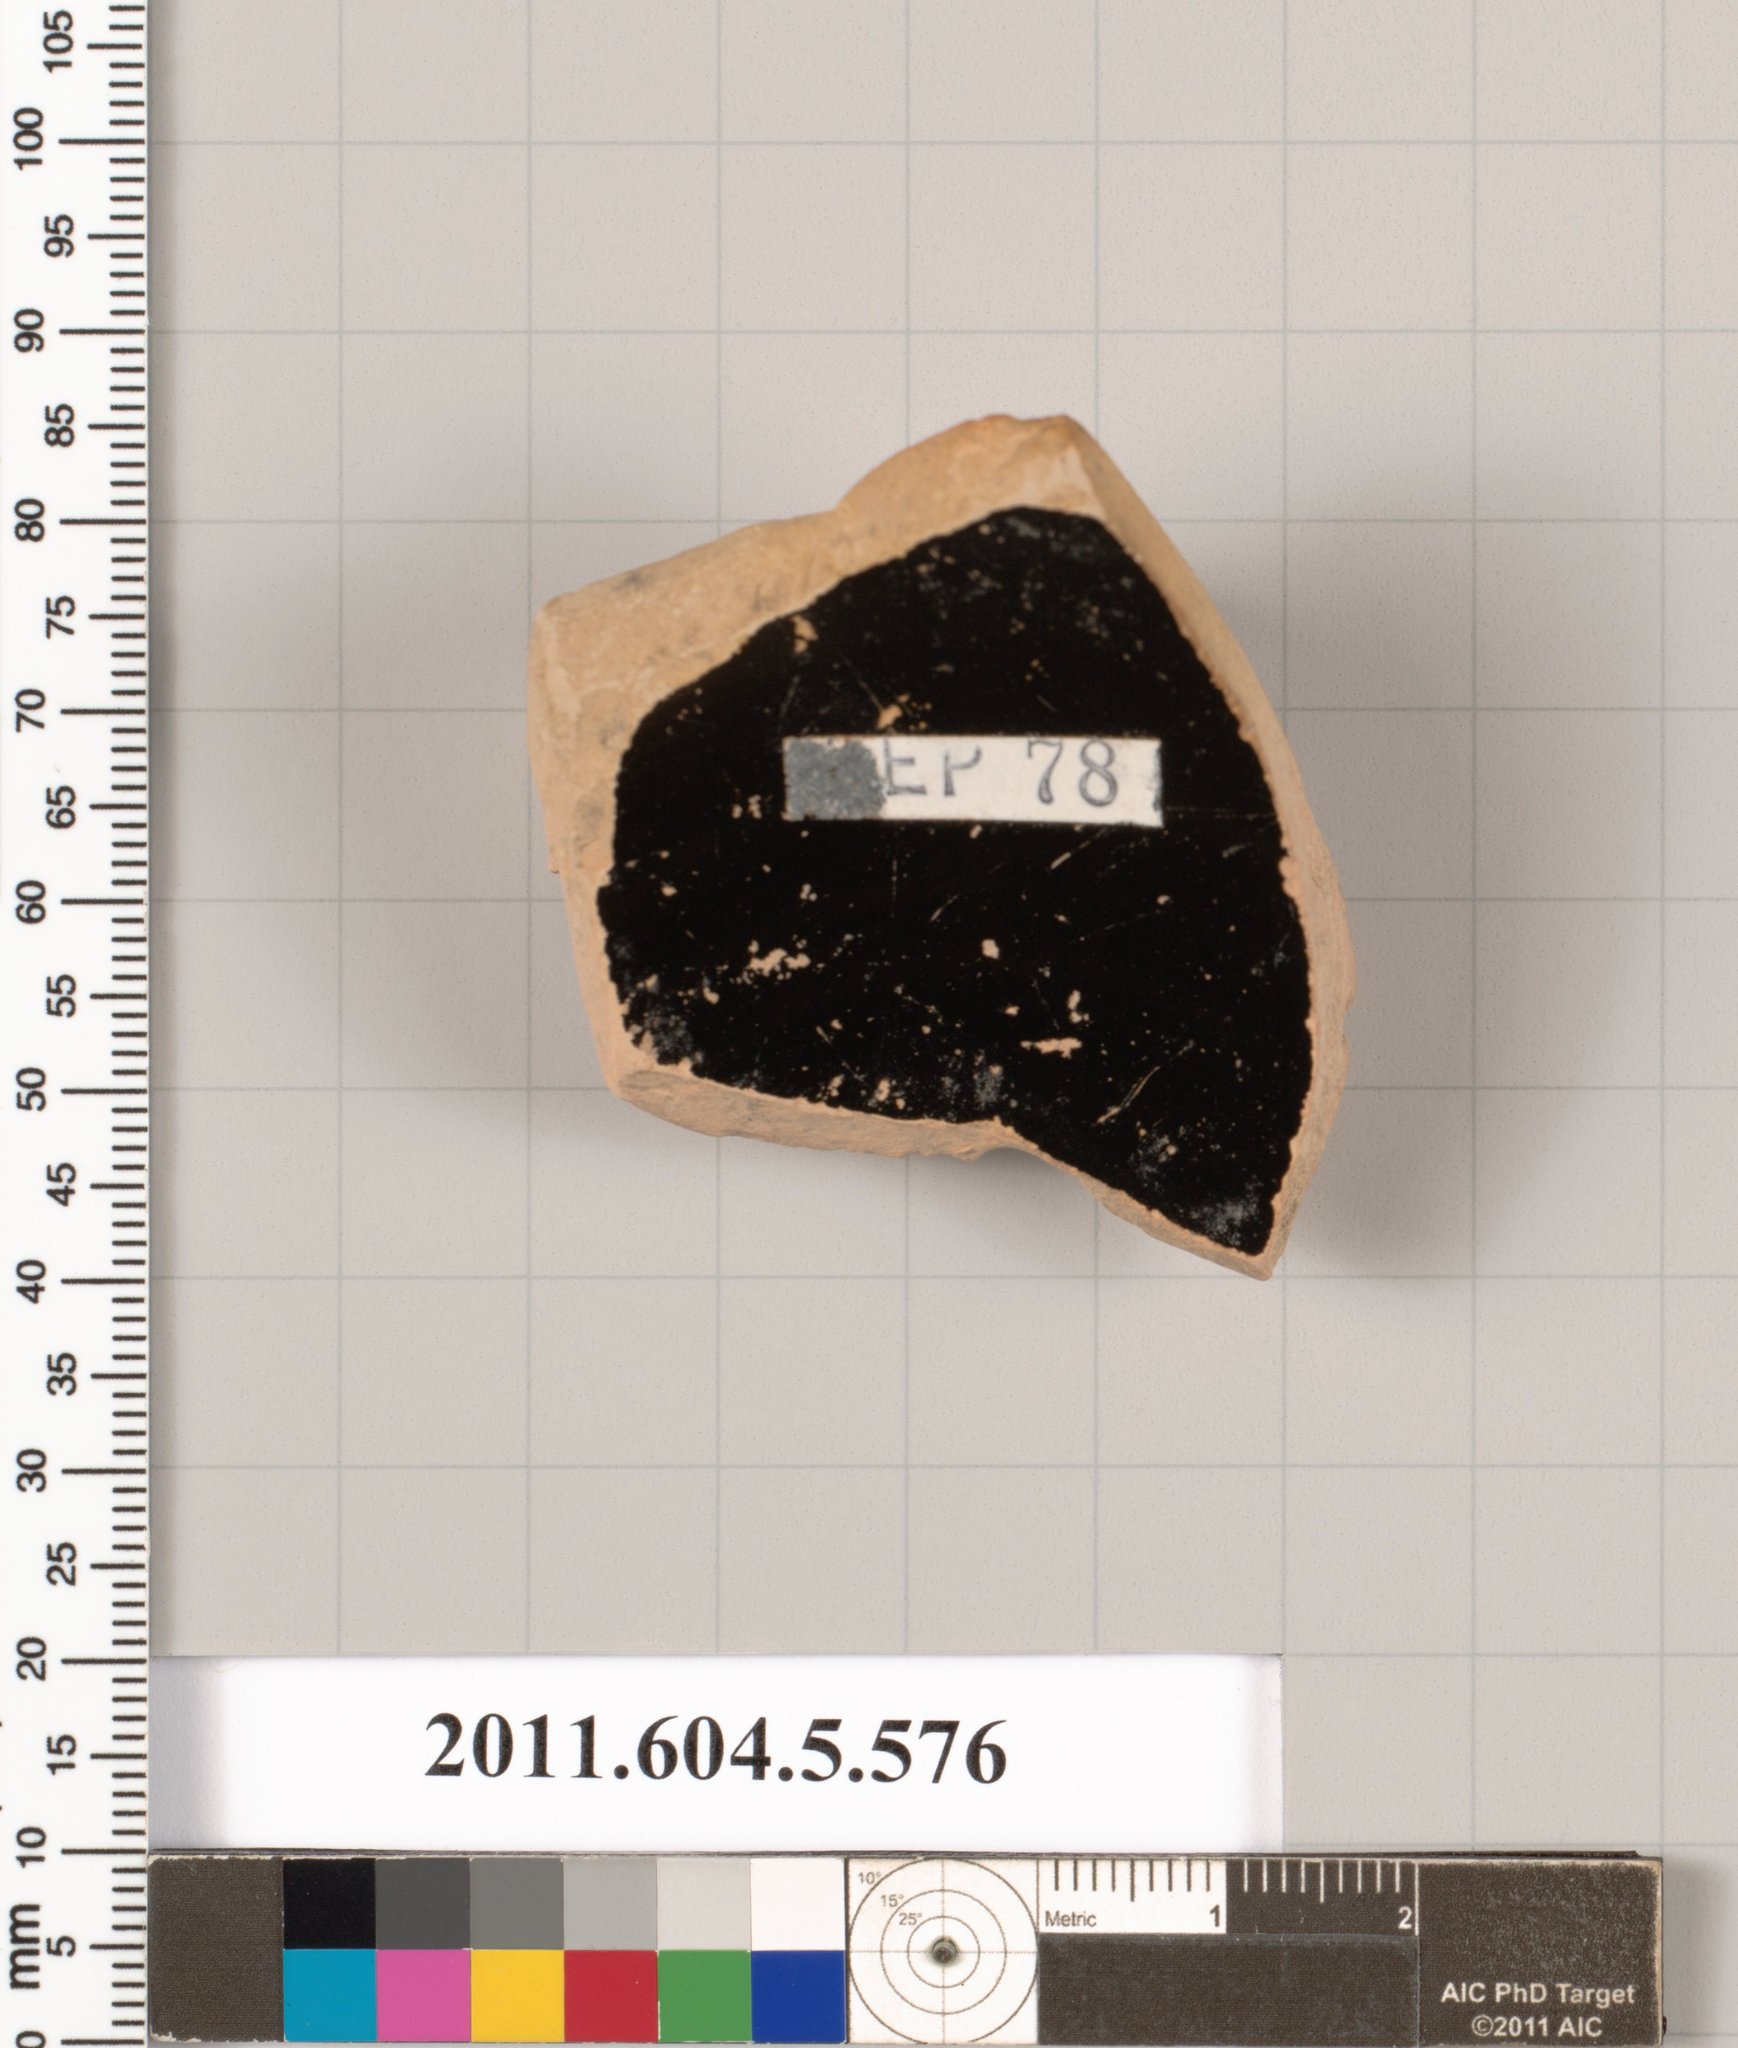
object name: stemless kylix fragment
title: Terracotta fragment of a stemless kylix (drinking cup)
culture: greek, attic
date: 600-401 BCE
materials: terracotta